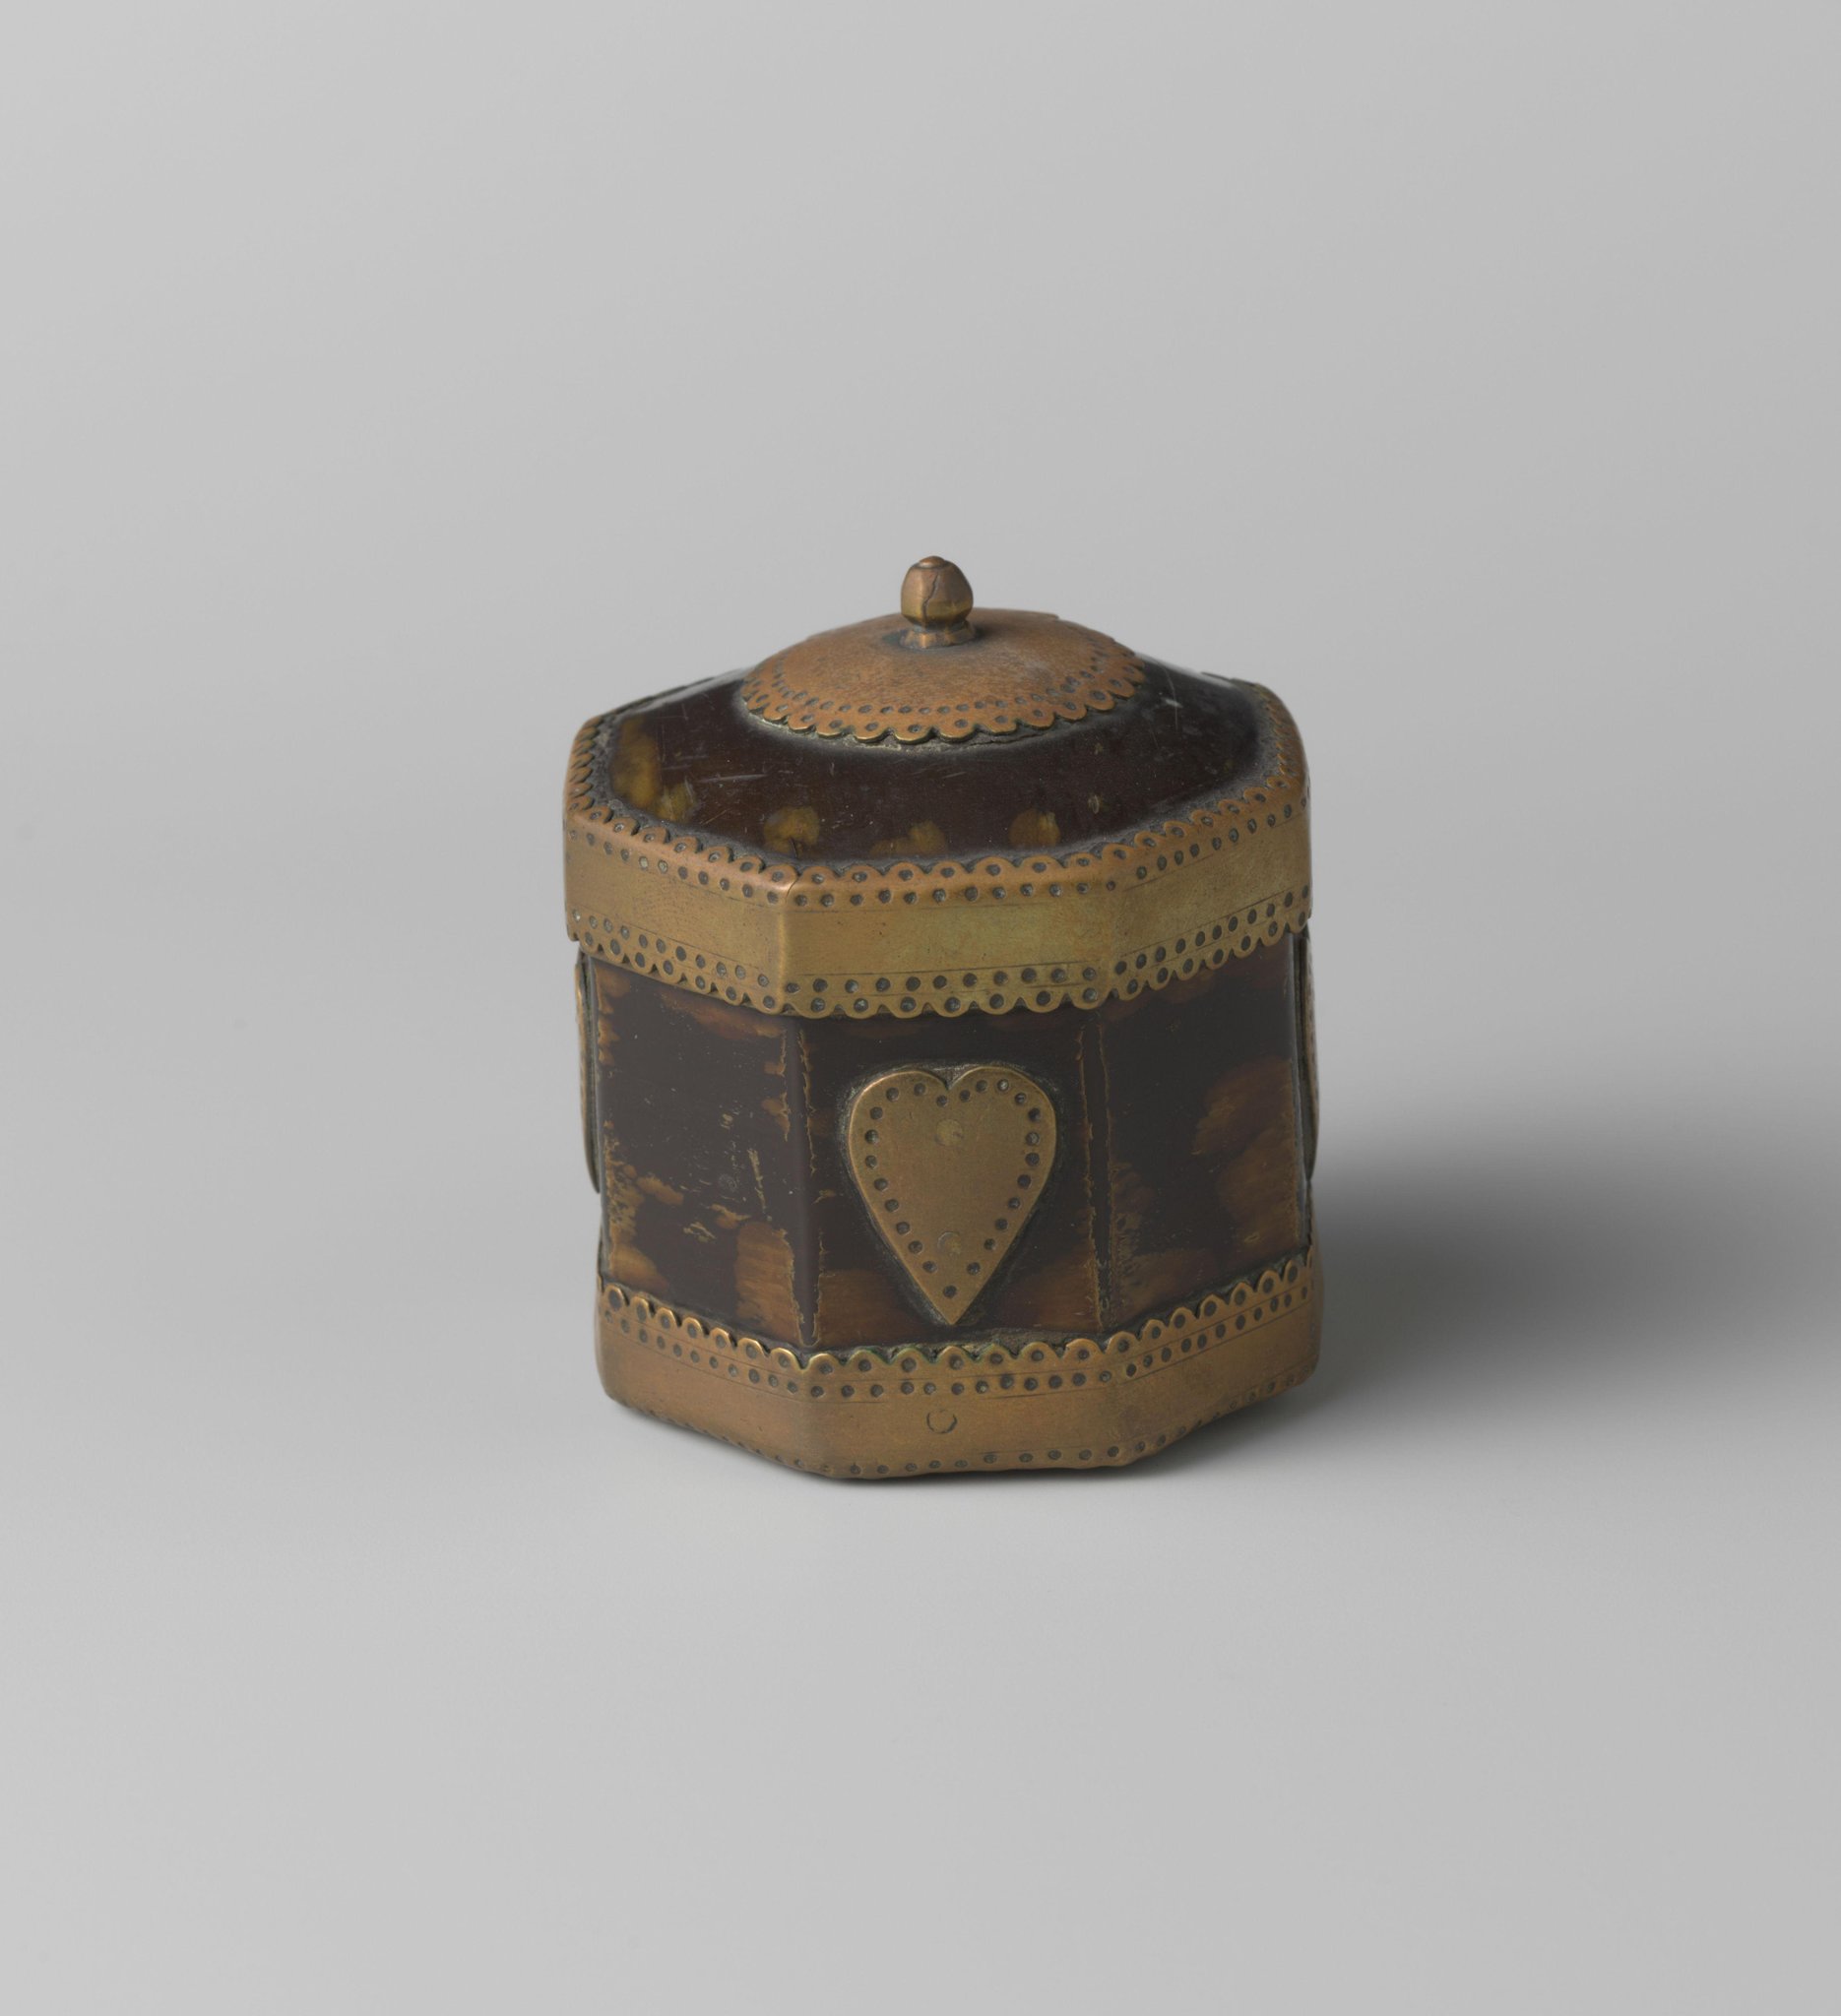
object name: box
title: Achtkantige doos van schildpad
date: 1600-1699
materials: copper, shell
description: Achtkantige doos van schildpad met koper gemonteerd. Met koperen knop op het deksel.